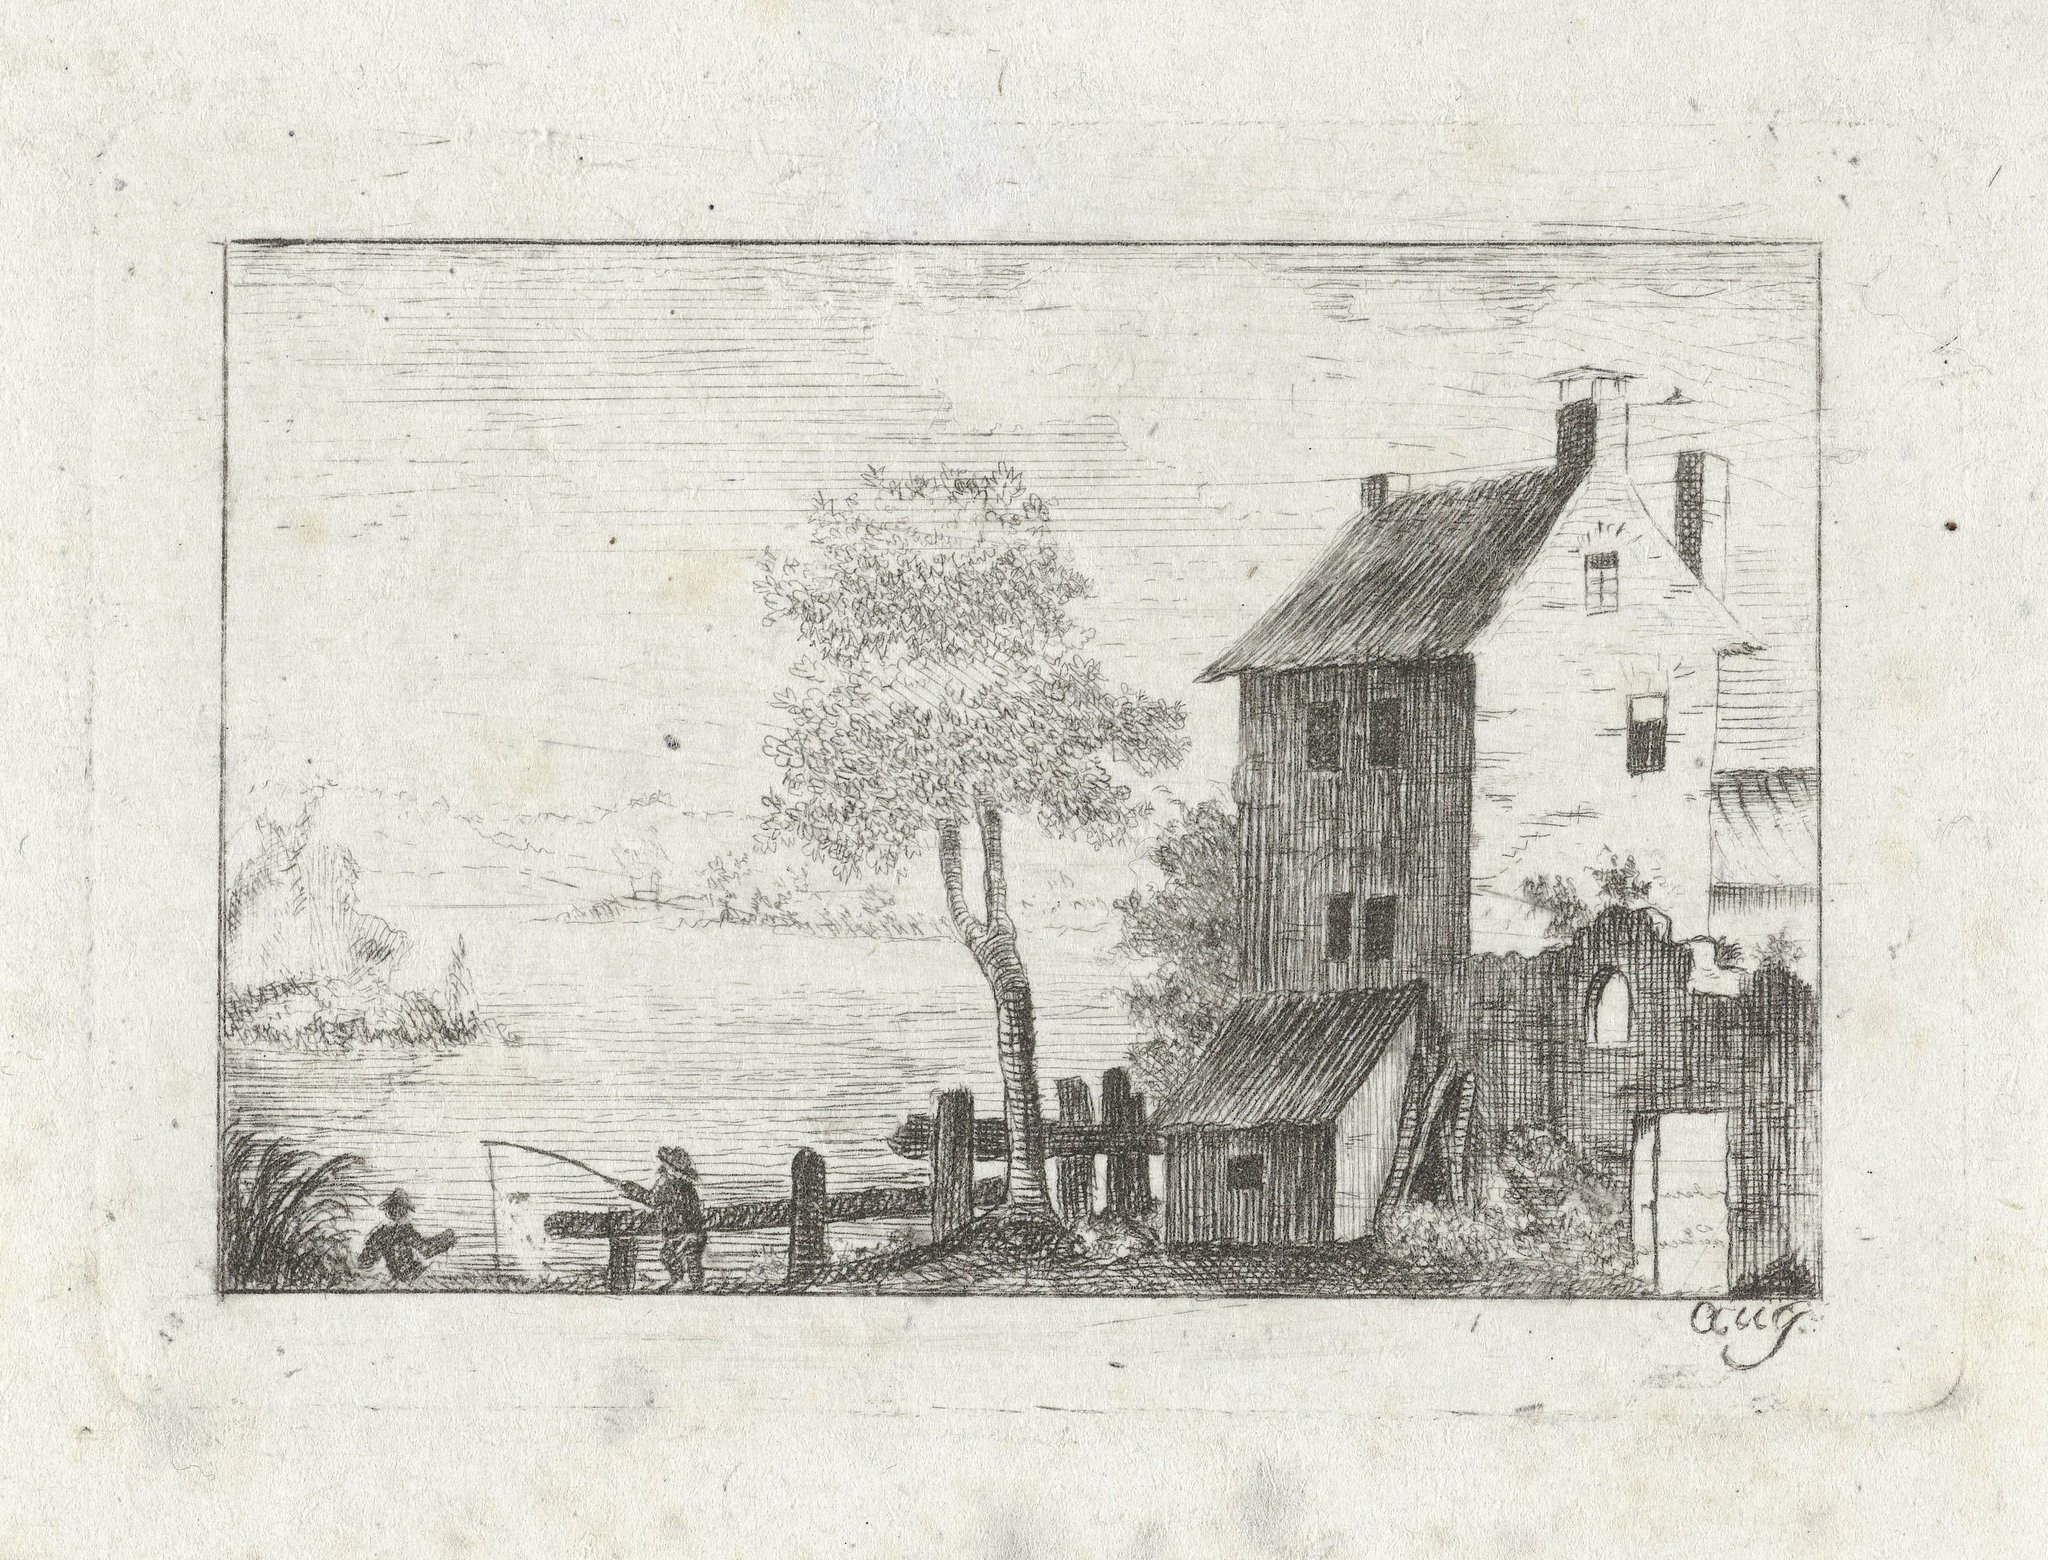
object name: print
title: Hengelende man bij een huis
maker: jan izaak van mansvelt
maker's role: print maker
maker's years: 1761-1802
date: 1771-1802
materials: paper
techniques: etching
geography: netherlands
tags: water course (+ landscape with figures, staffage), farm or solitary house in landscape, angling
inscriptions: collector's mark: Lugt 2228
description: Een rivierlandschap met rechts een huis en op de voorgrond een hengelende figuur. Rechtsonder: Aug.